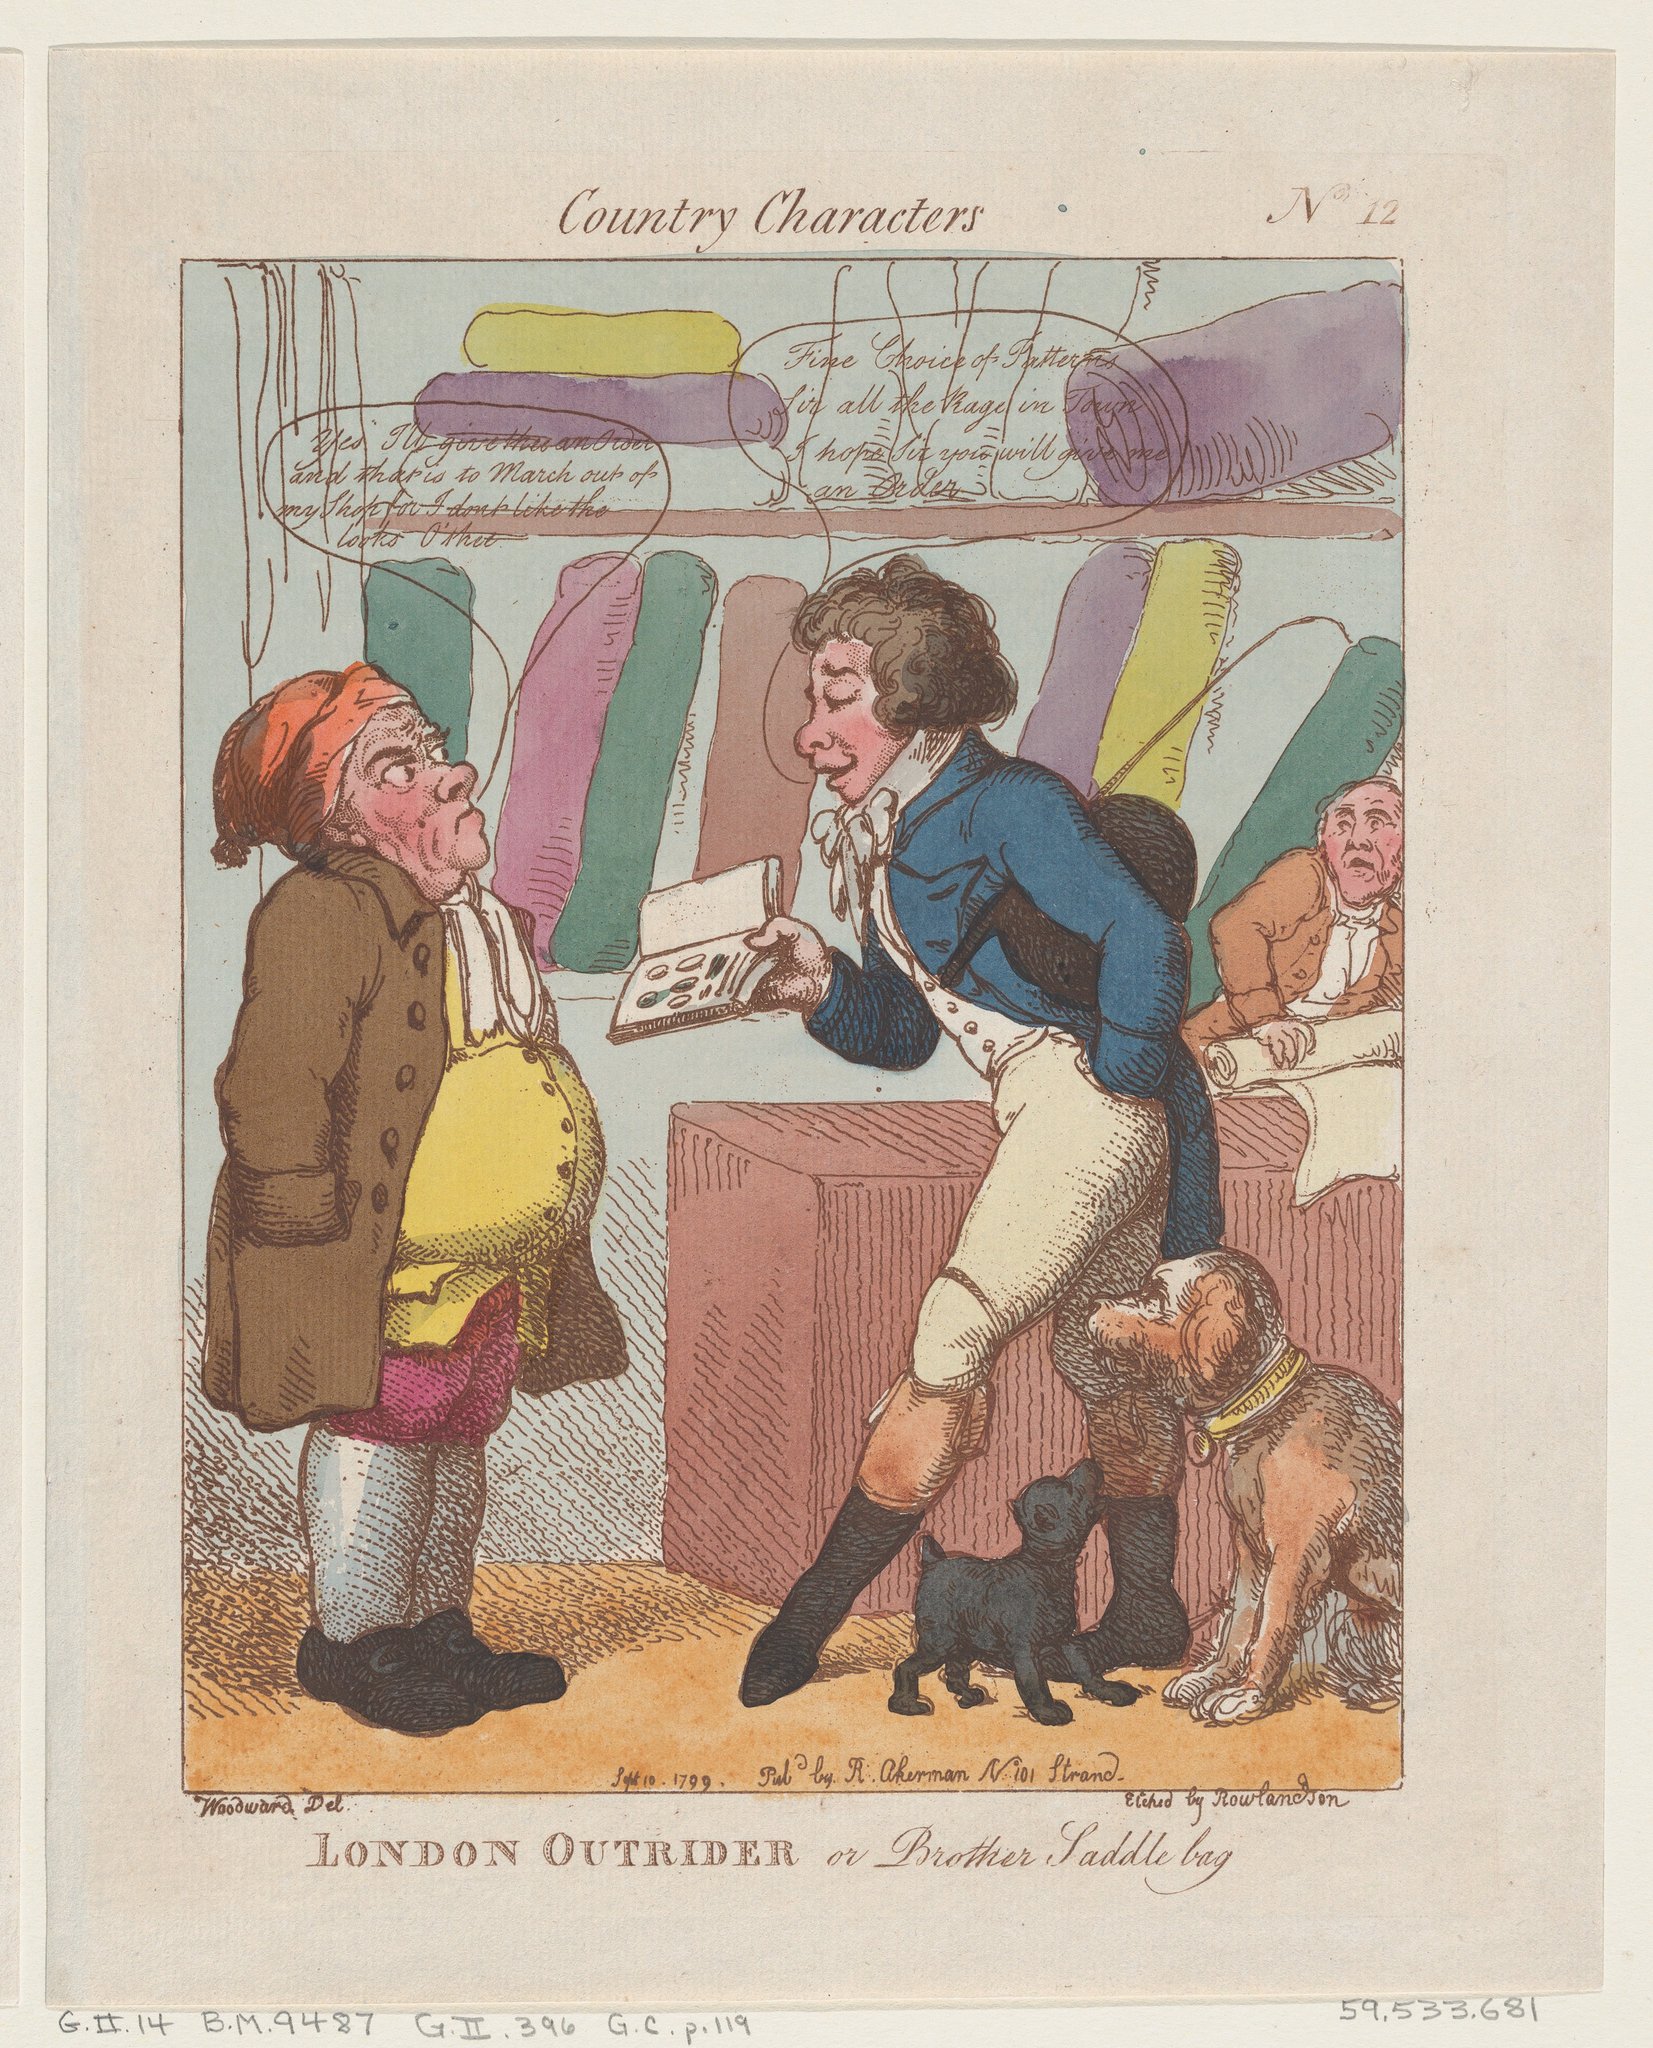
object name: print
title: London Outrider, or Brother Saddlebag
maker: thomas rowlandson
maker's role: artist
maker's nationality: british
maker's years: 1757-1827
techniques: etching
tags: men,dogs